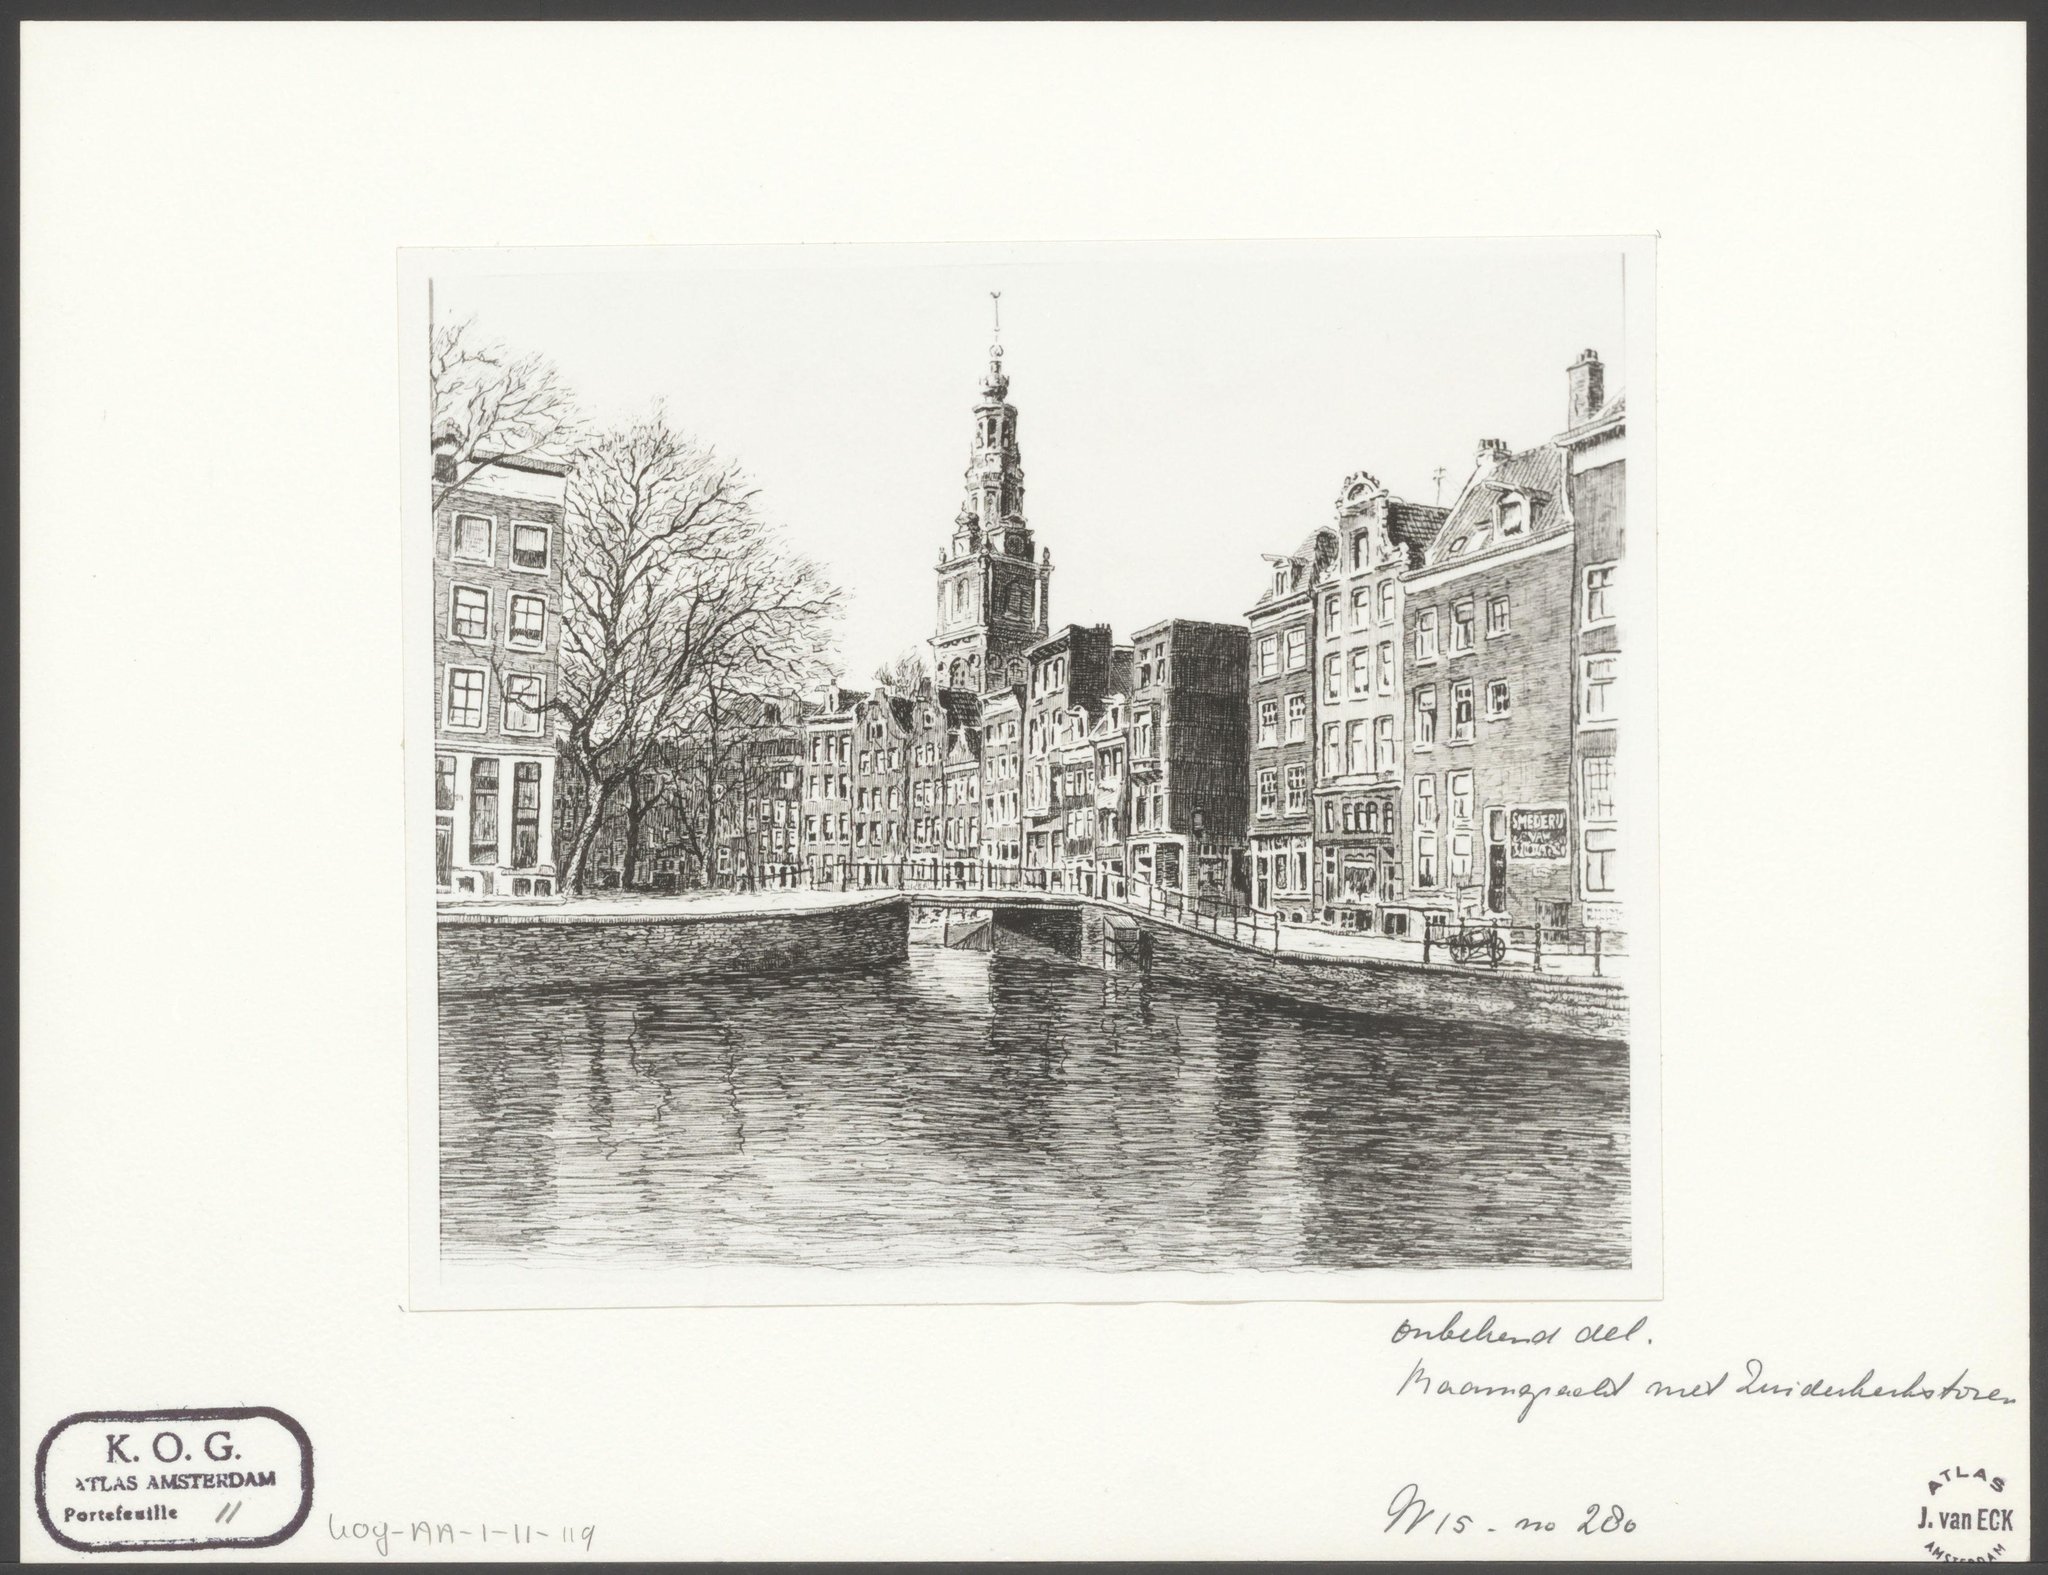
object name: reproduction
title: Fotoreproductie van een gezicht op de Raamgracht met de Zuiderkerkstoren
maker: Anonymous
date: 1880-1975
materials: paper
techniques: gelatin silver print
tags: tower, clock tower ~ monumental adornment, city-view in general; 'veduta', canal, bridge in city across river, canal, etc.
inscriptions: collector's mark: Lugt 800a, inscription: ‘onbekend del. / Raamgracht met Zuiderkerkstoren / N15. no 280’, collector's mark: ‘11’ Lugt 1641b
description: Onderwerpsrubriek binnen de Atlas Amsterdam: Raadhuisstraat, Raamgracht, Raamplein, Rapenburgerstraat, Reguliersgracht, Reguliersbreestraat.